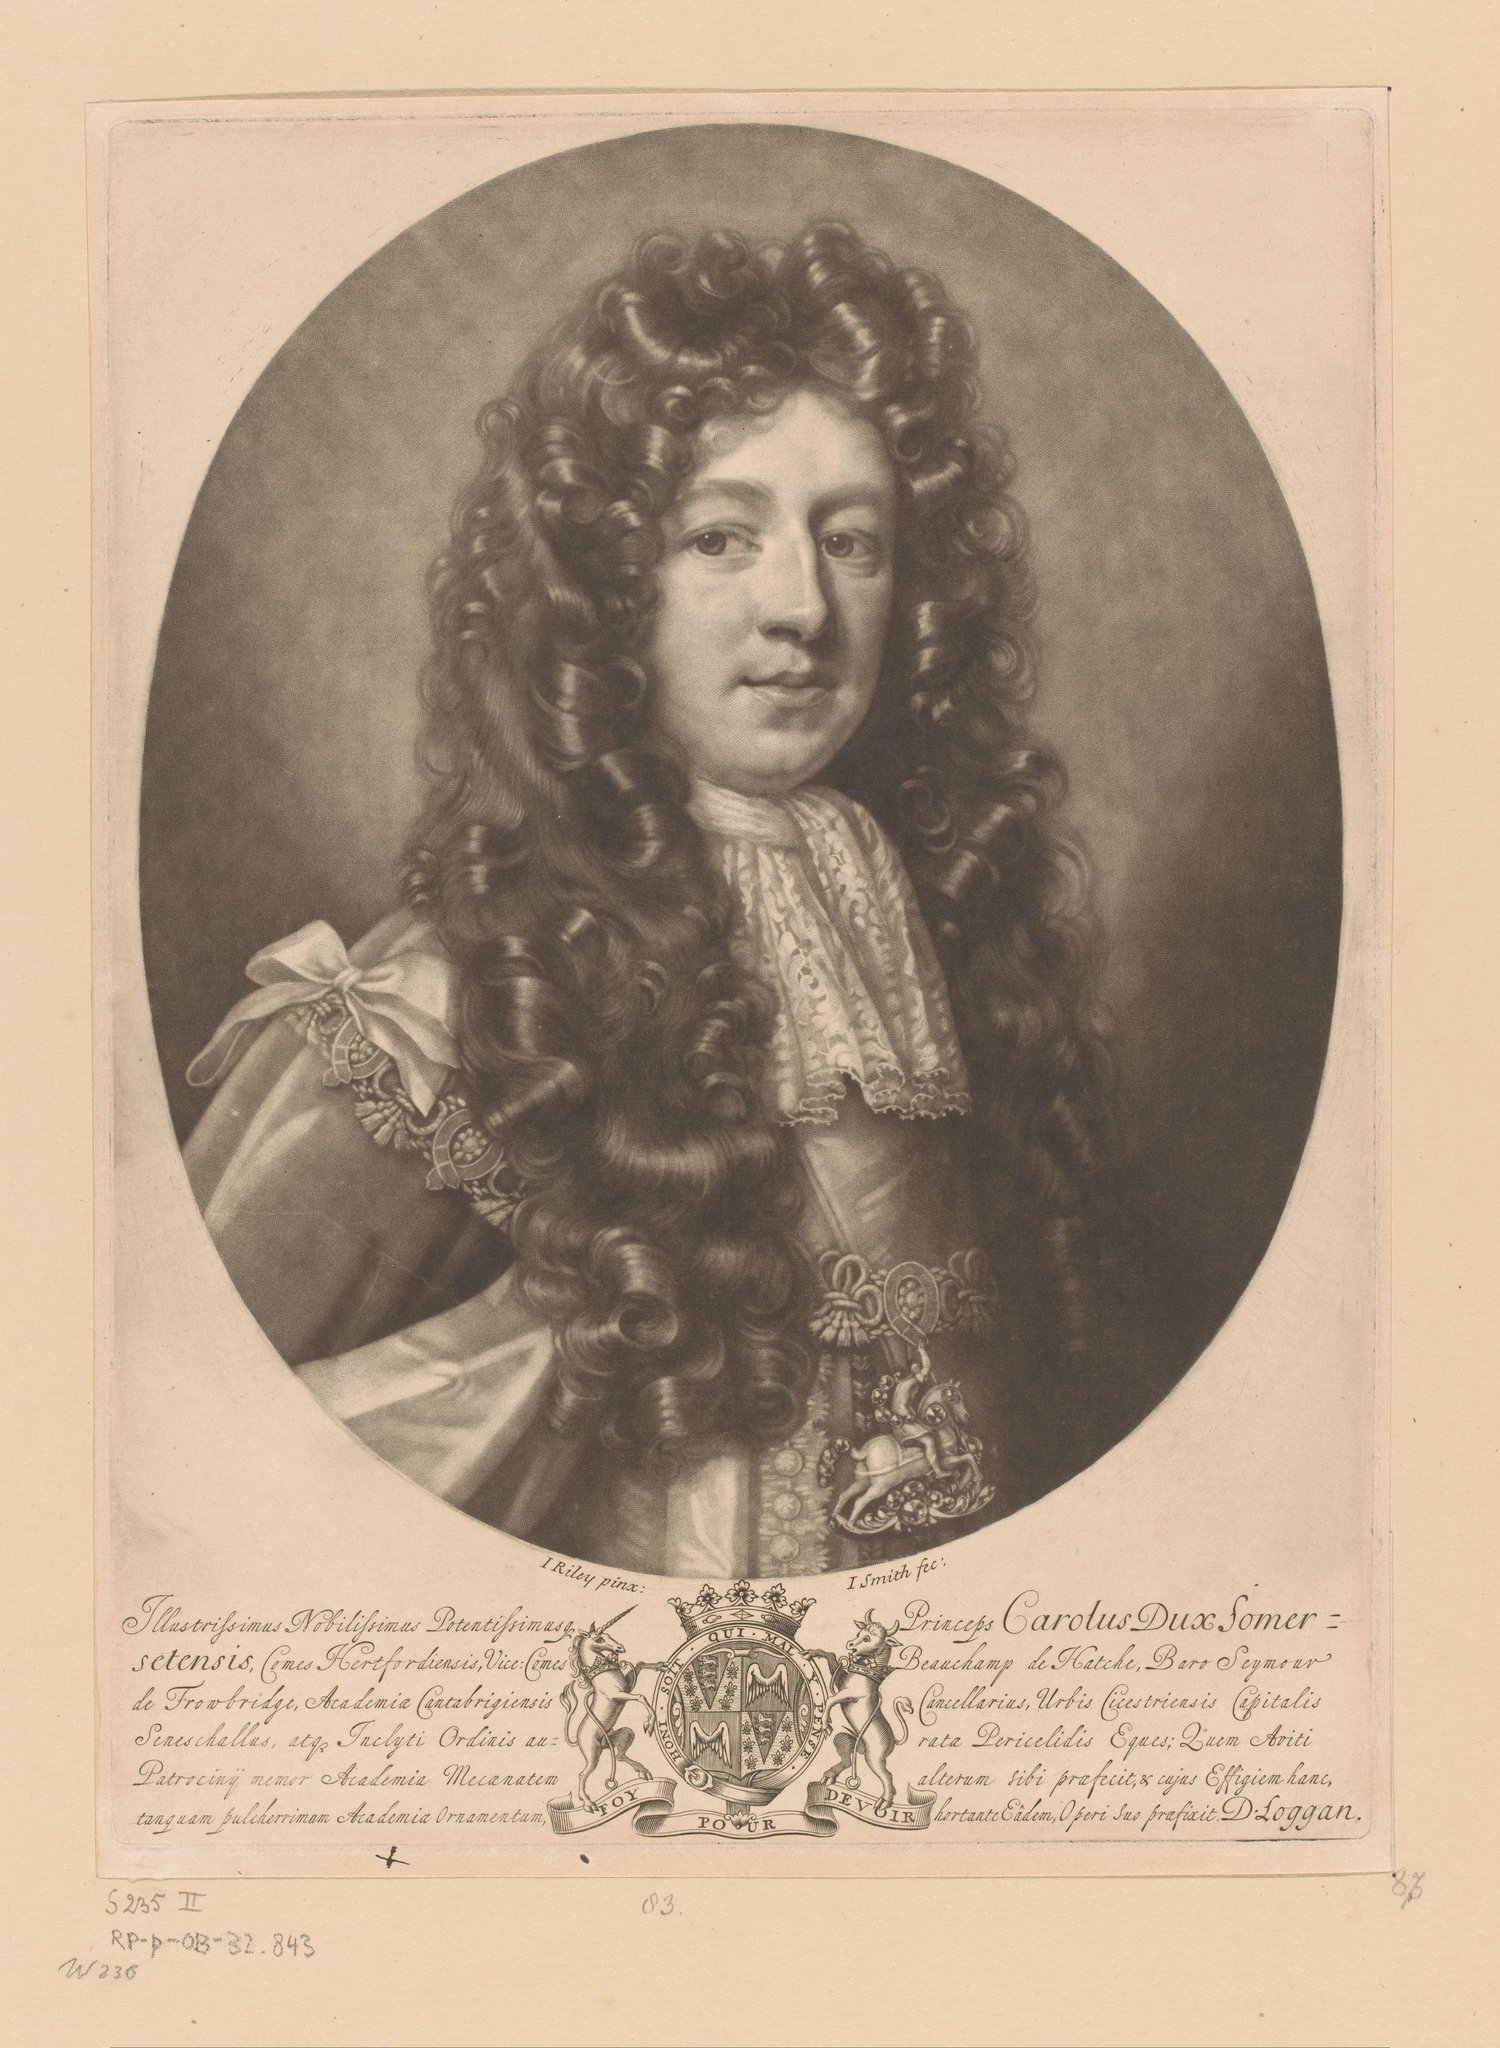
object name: print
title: Portret van Charles Seymour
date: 1672-1742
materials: paper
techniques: mezzotint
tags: charles seymour (6e hertog van somerset), jury, historical persons, politician, e.g. party leader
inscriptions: collector's mark: Lugt 240